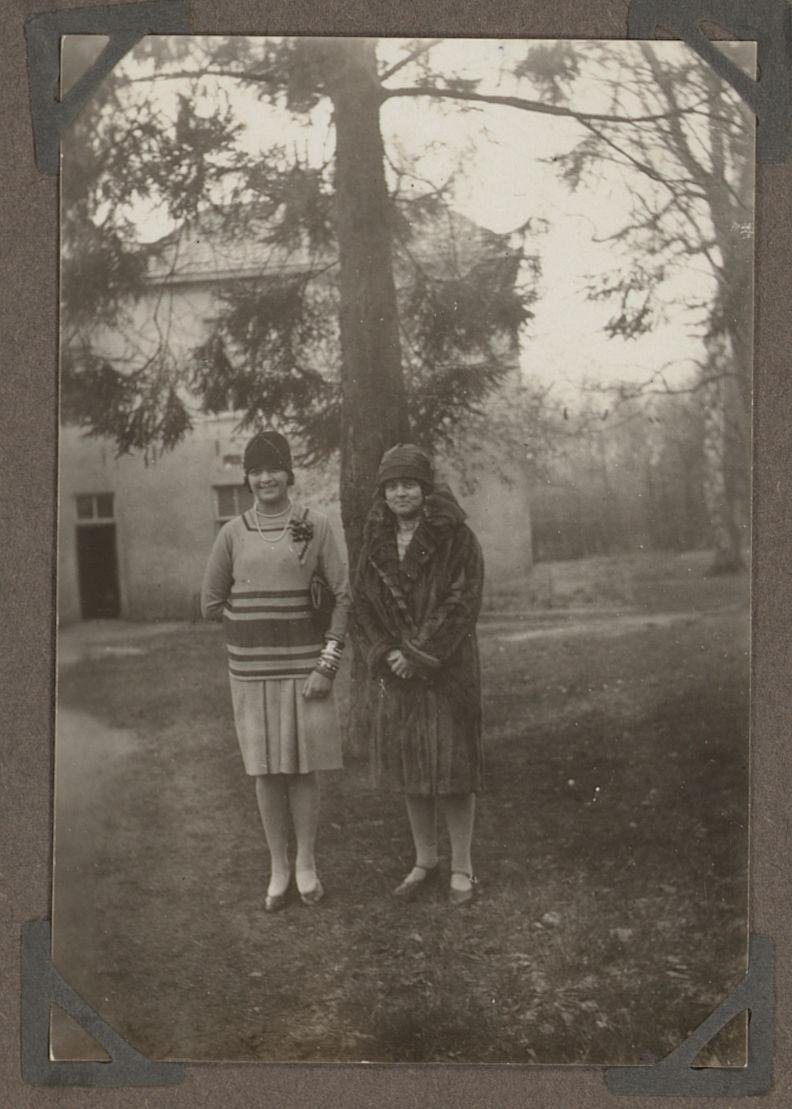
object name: photograph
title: Wilhelmina van Zijll de Jong en Henriëtte Wassink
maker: Anonymous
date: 1930-1935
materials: paper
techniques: gelatin silver print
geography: netherlands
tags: batavia, the hague, henriëtte wassink, wilhelmina van zijll de jong, mother and daughter(s) (family group), netherlands